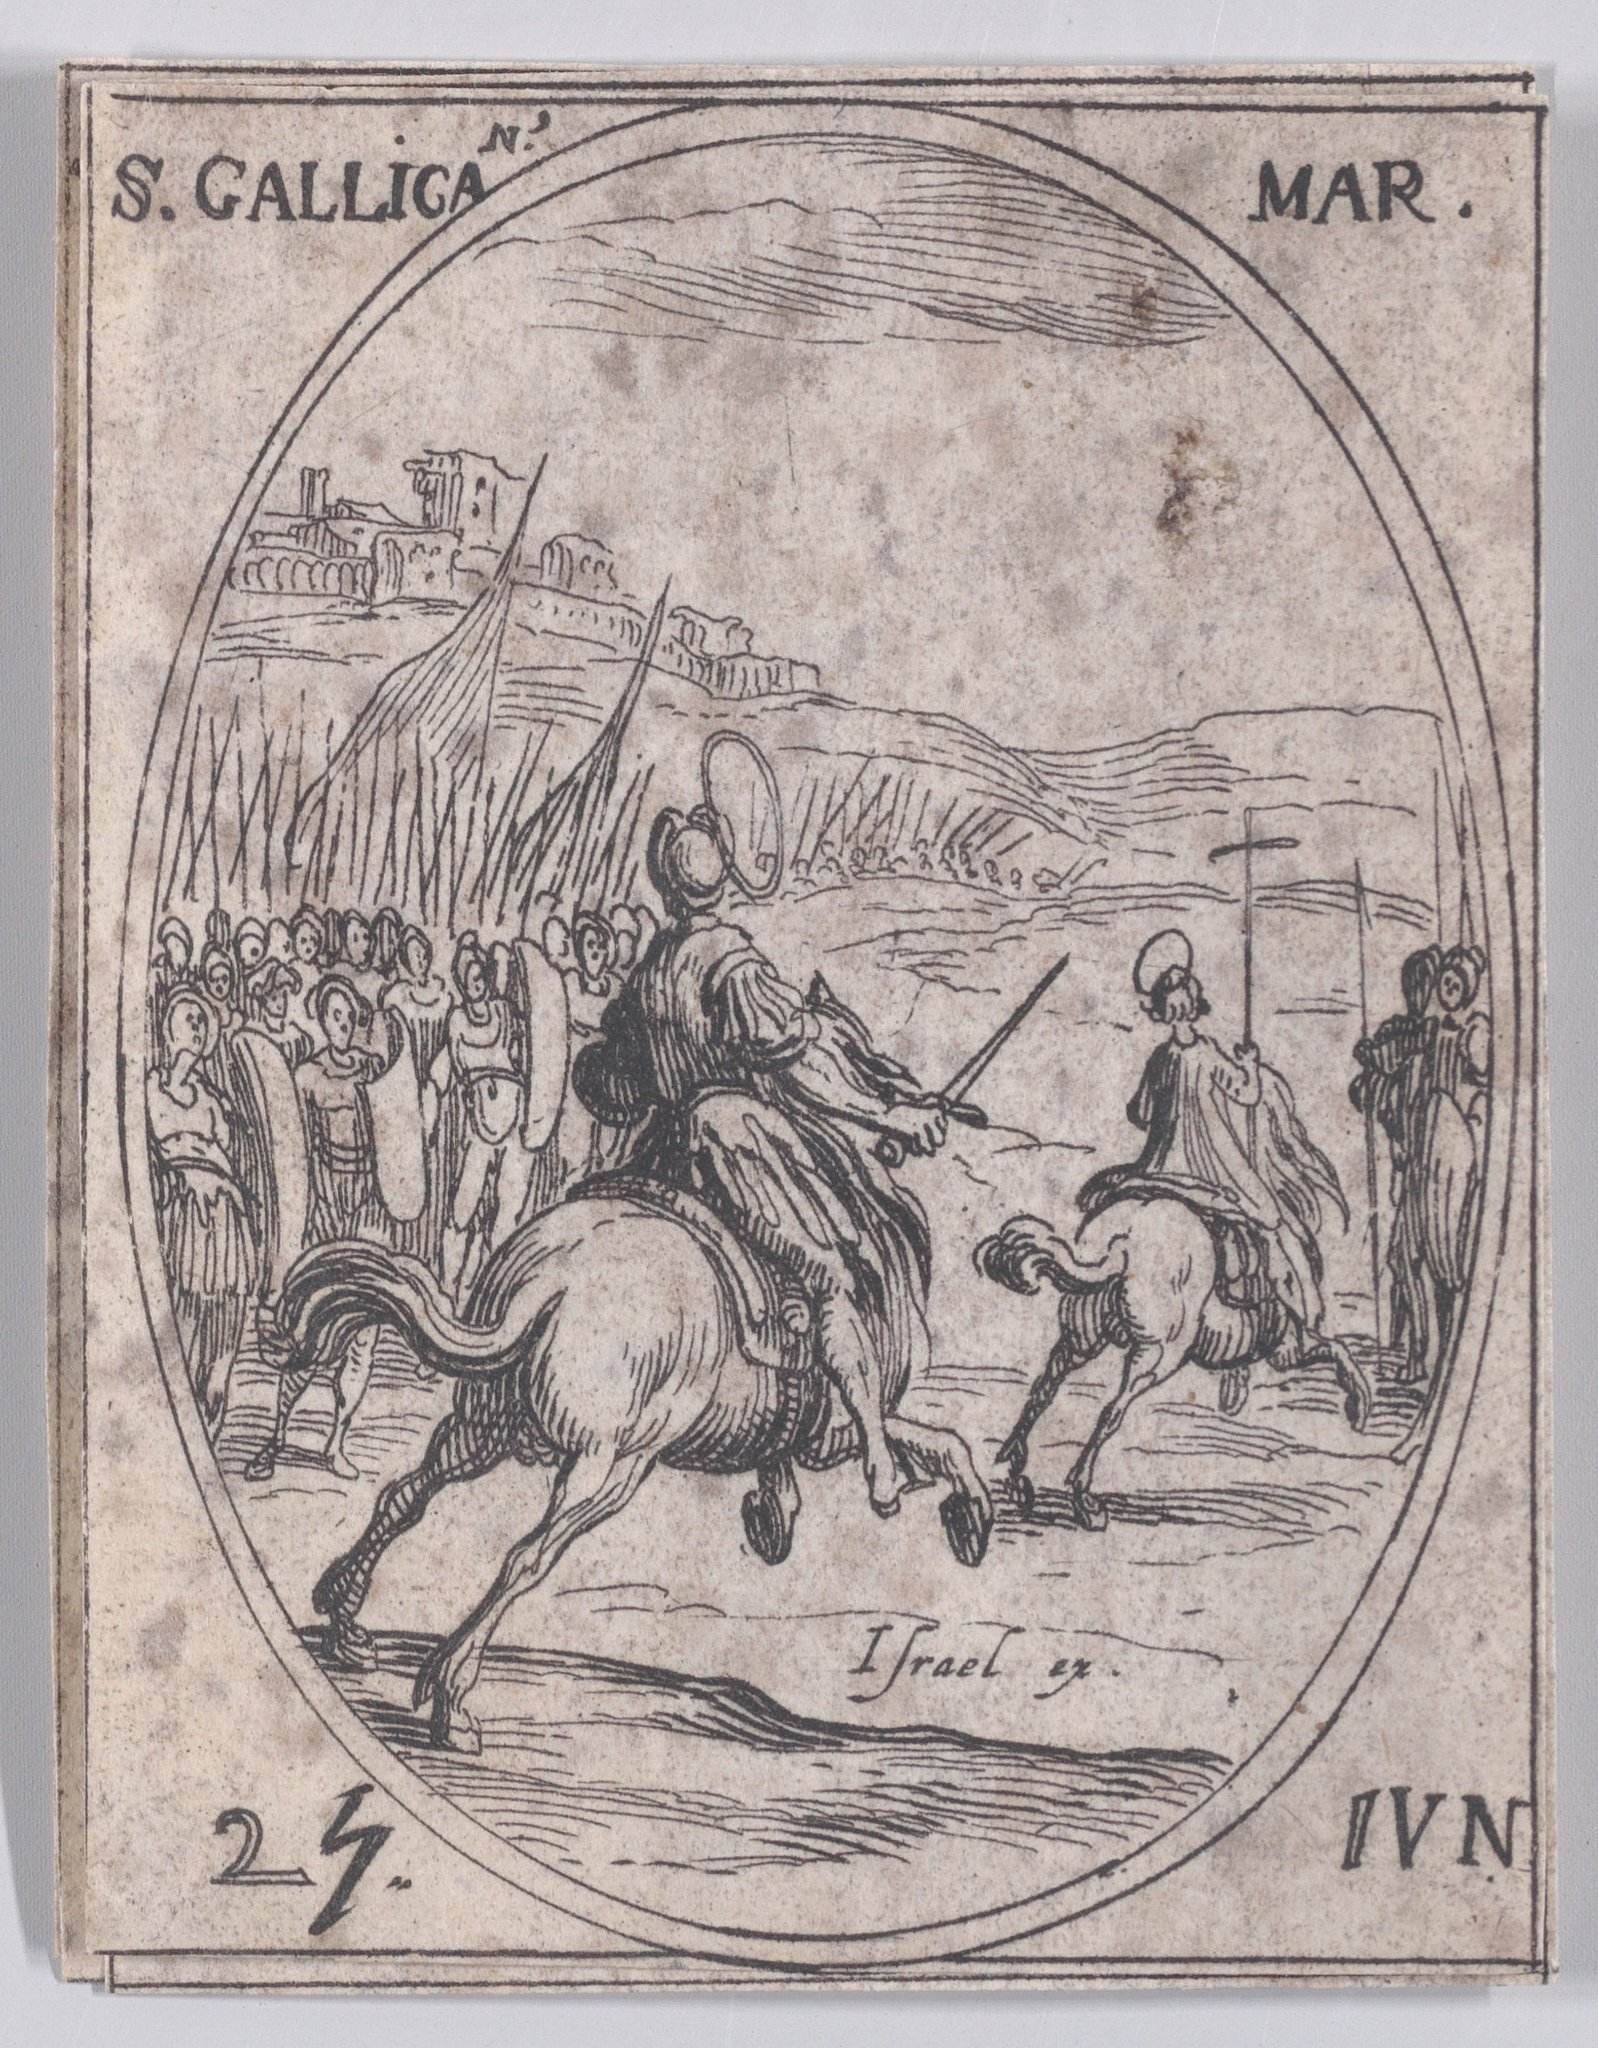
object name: print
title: S. Gallican, martyr (St. Gallicanus, Martyr), June 25th, from "Les Images De Tous Les Saincts et Saintes de L'Année" (Images of All of the Saints and Religious Events of the Year)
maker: jacques callot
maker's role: artist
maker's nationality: french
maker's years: 1592-1635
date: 1636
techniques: etching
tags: men,horses,saints